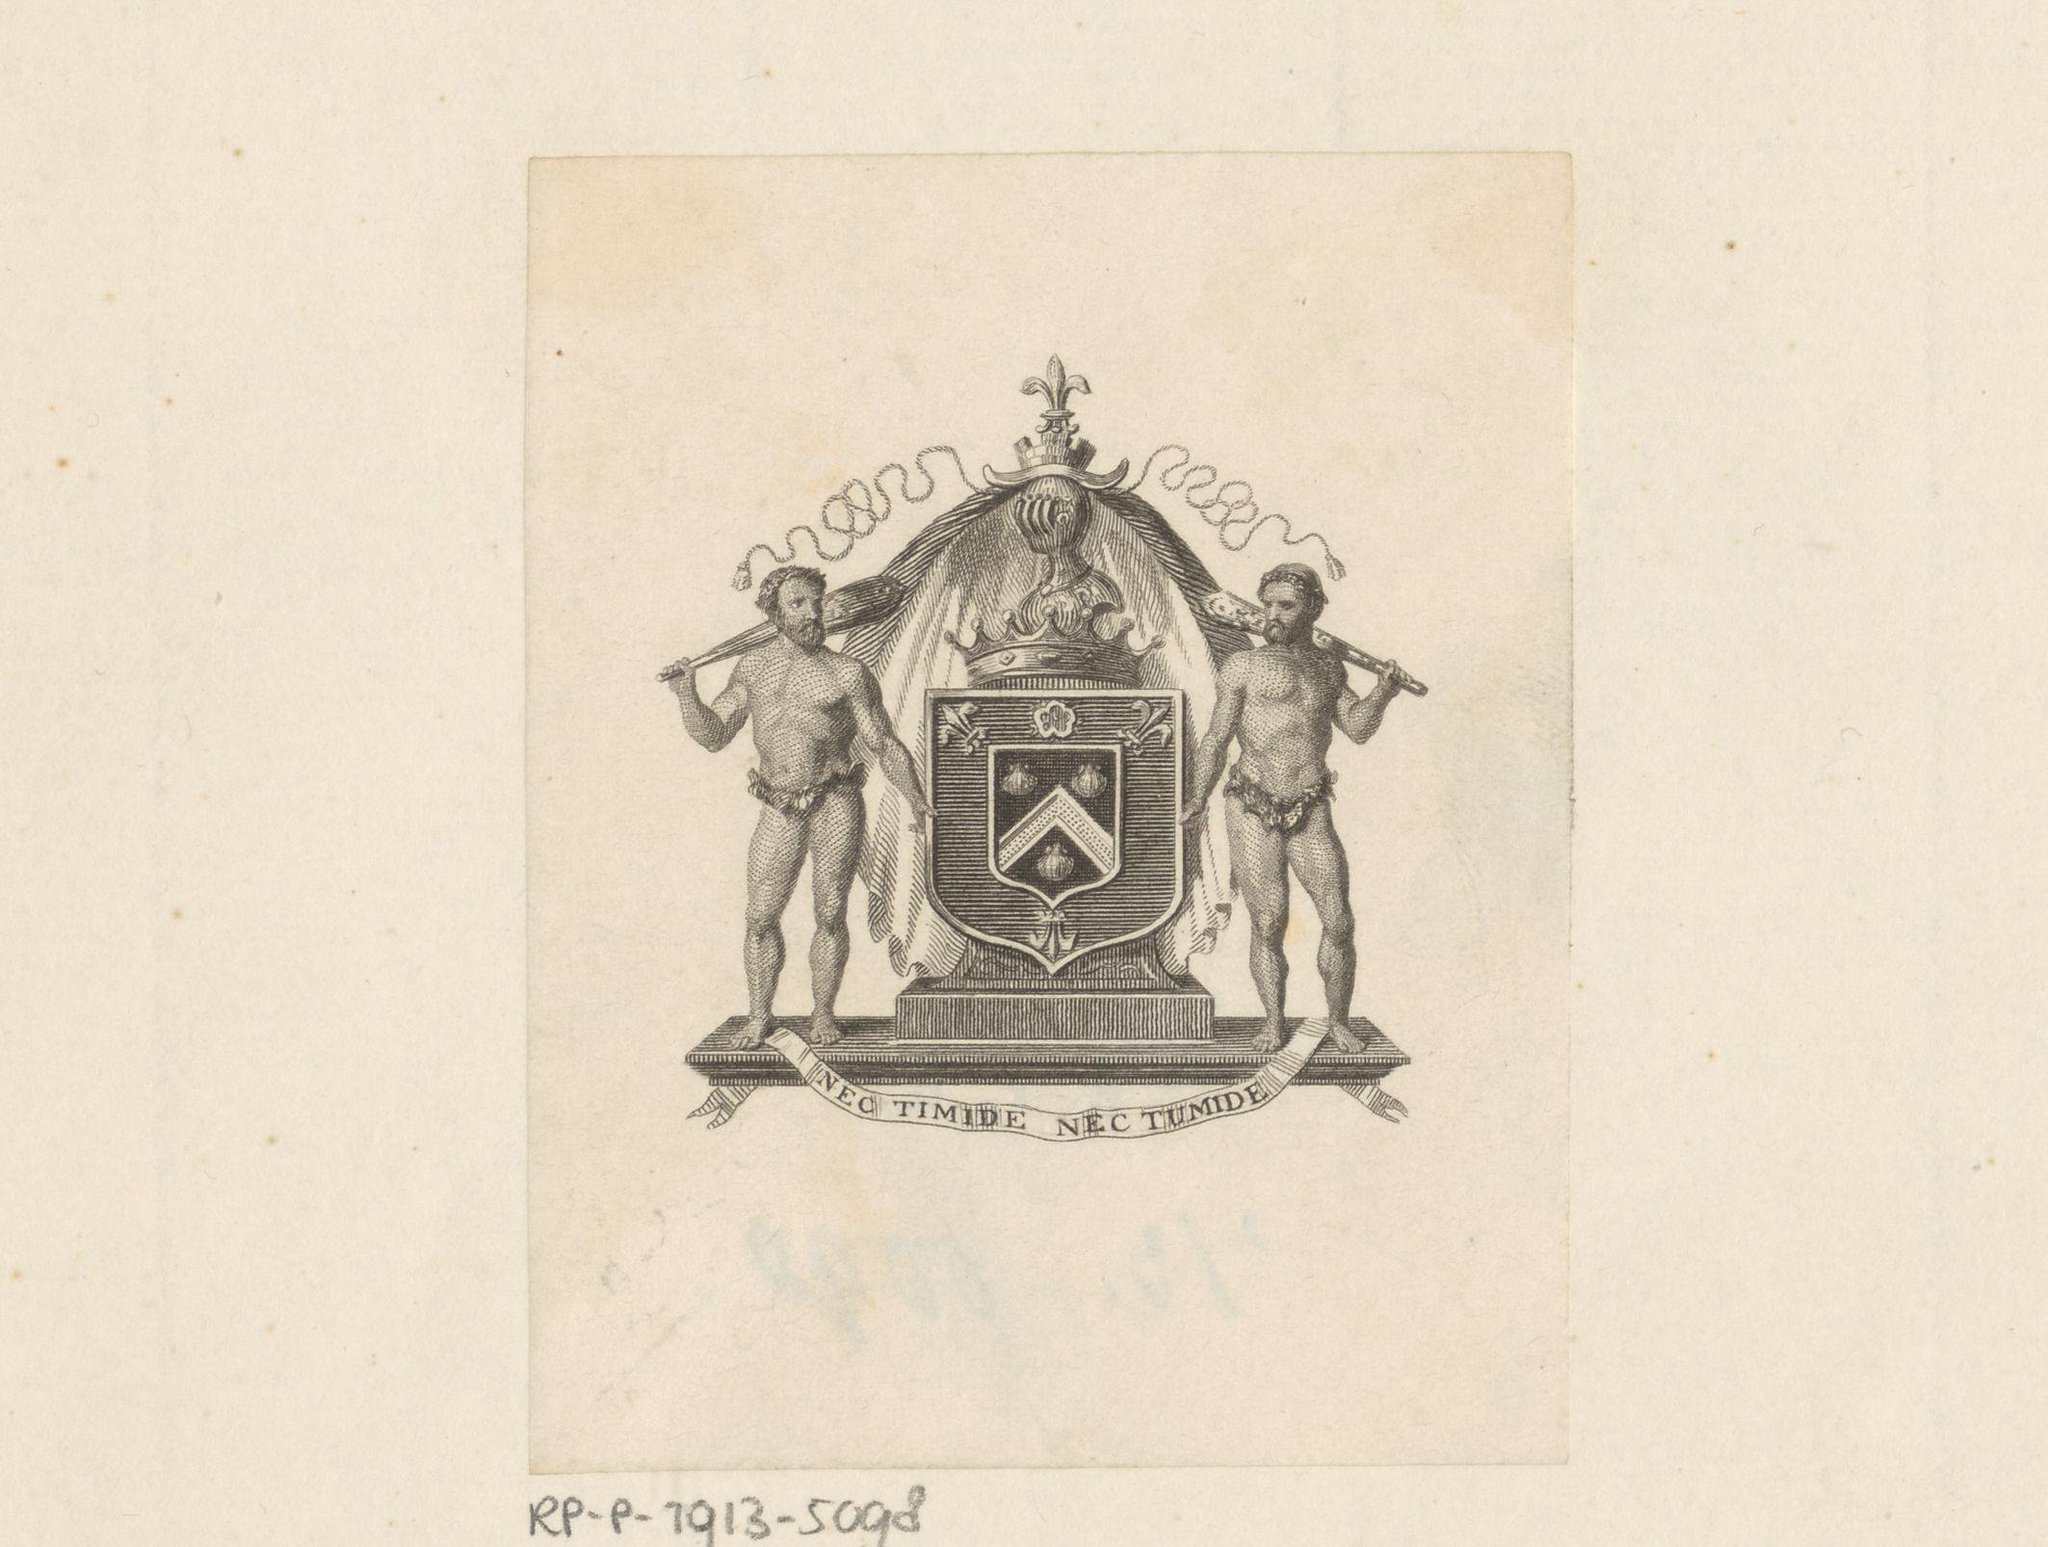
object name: bookplate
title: Ex libris van Huyssen van Kattendijke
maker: Anonymous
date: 1800-1899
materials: paper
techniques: engraving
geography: netherlands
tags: wild man, wodewose, woodehouse, armorial bearing, heraldry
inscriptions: collector's mark: Lugt 2233, collector's mark: Lugt 2760